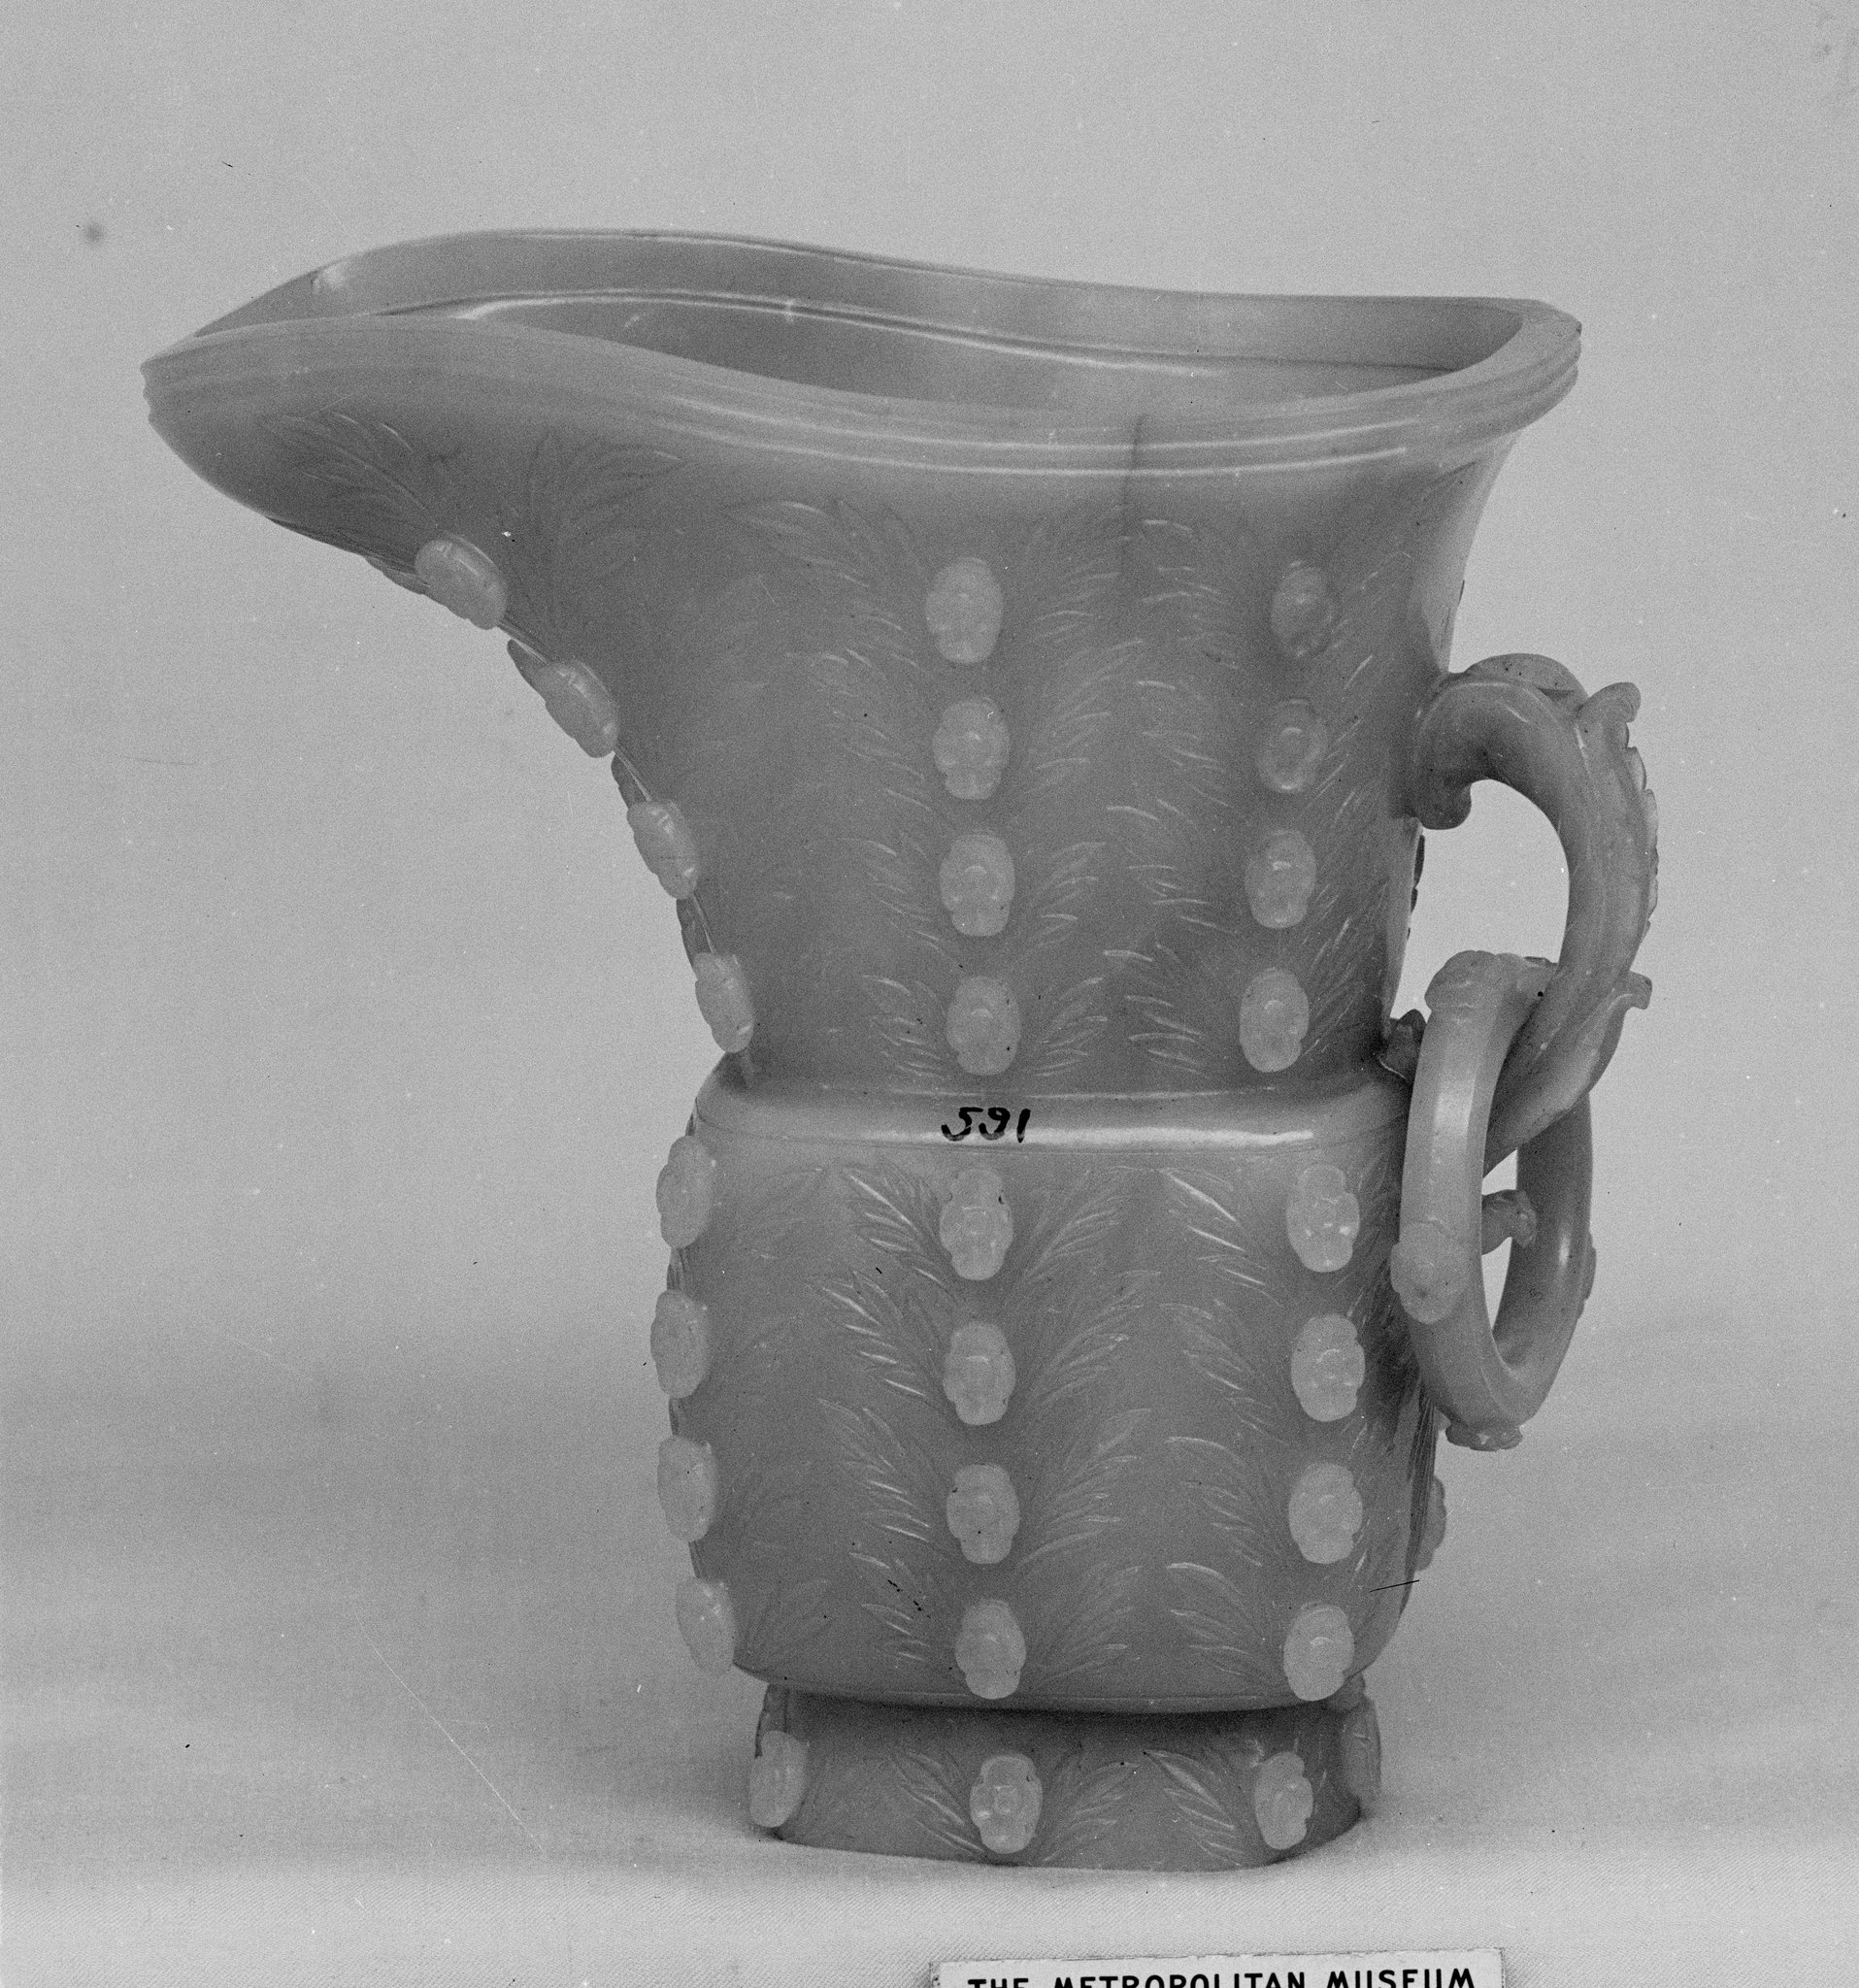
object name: wine pitcher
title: Wine-pitcher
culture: chinese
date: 1736-1795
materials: jade